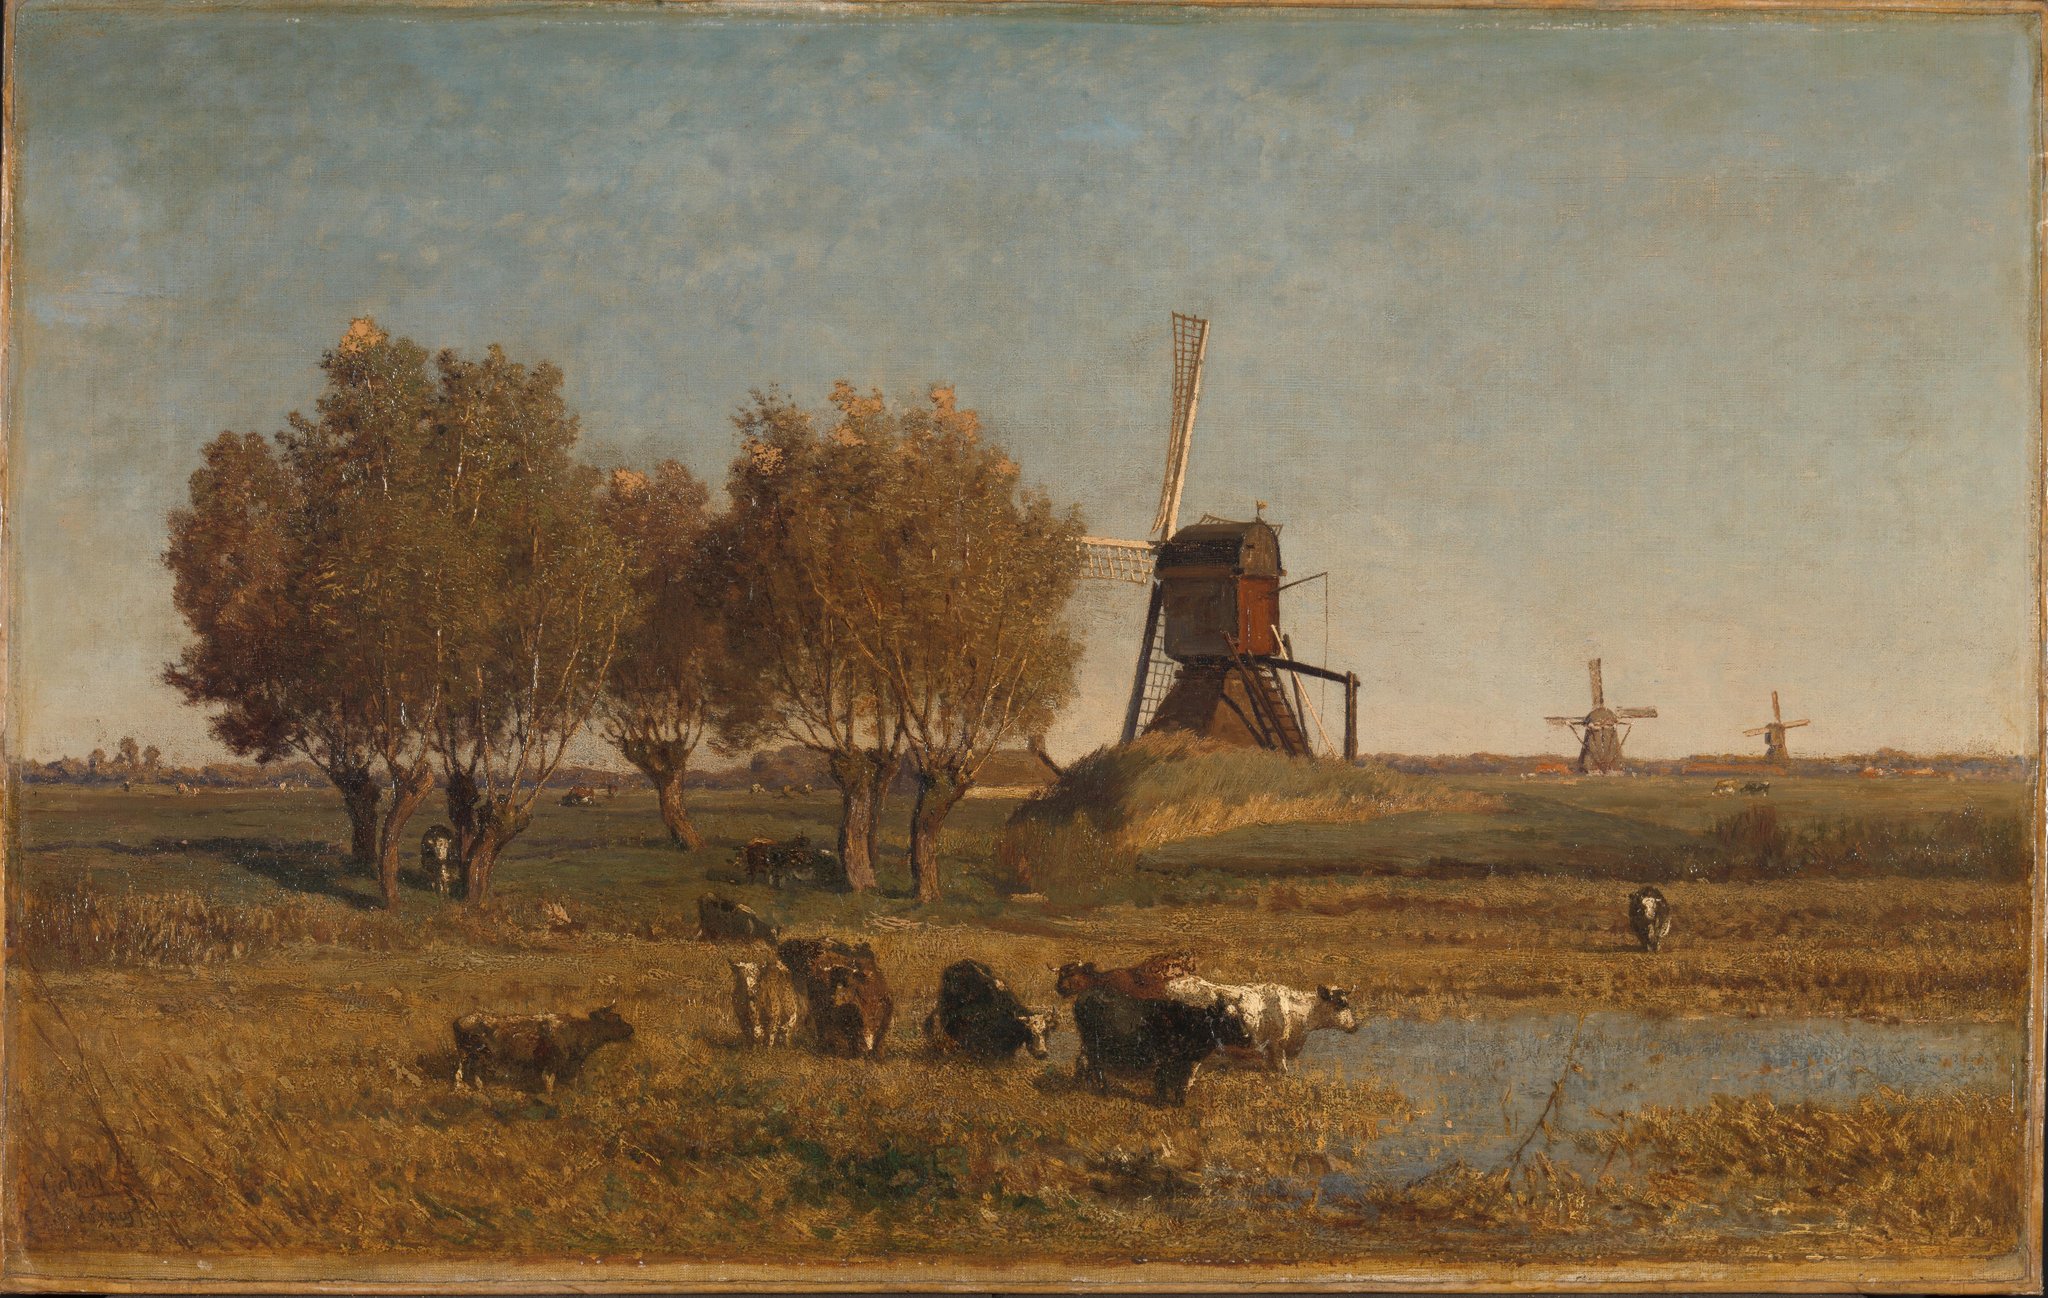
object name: painting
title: De Winkel near Abcoude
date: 1877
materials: canvas, oil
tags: meadow, pasture, windmill in landscape, river (+ landscape with figures, staffage), abcoude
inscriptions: signature: ‘Gabriel ft. de Haas figur.’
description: This painting is a collaboration between two painters. Gabriël was known for his polder landscapes, De Haas for his accomplished rendering of cattle. The result is a truly Dutch picture with a windmill, willow trees and cows by the small river Winkel at Abcoude, near Amsterdam. Both artists signed at the lower left: Gabriel ft De Haas fig. That is to say that Gabriël painted the picture and De Haas added the figures.